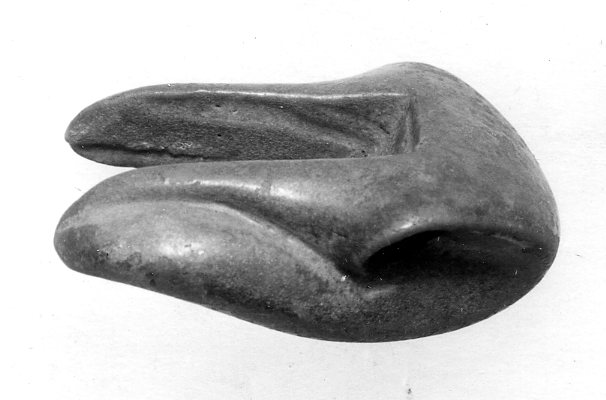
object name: architectural ornament, cobra head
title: Cobra head for architectural frieze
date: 1550-1295 BCE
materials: faience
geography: egypt